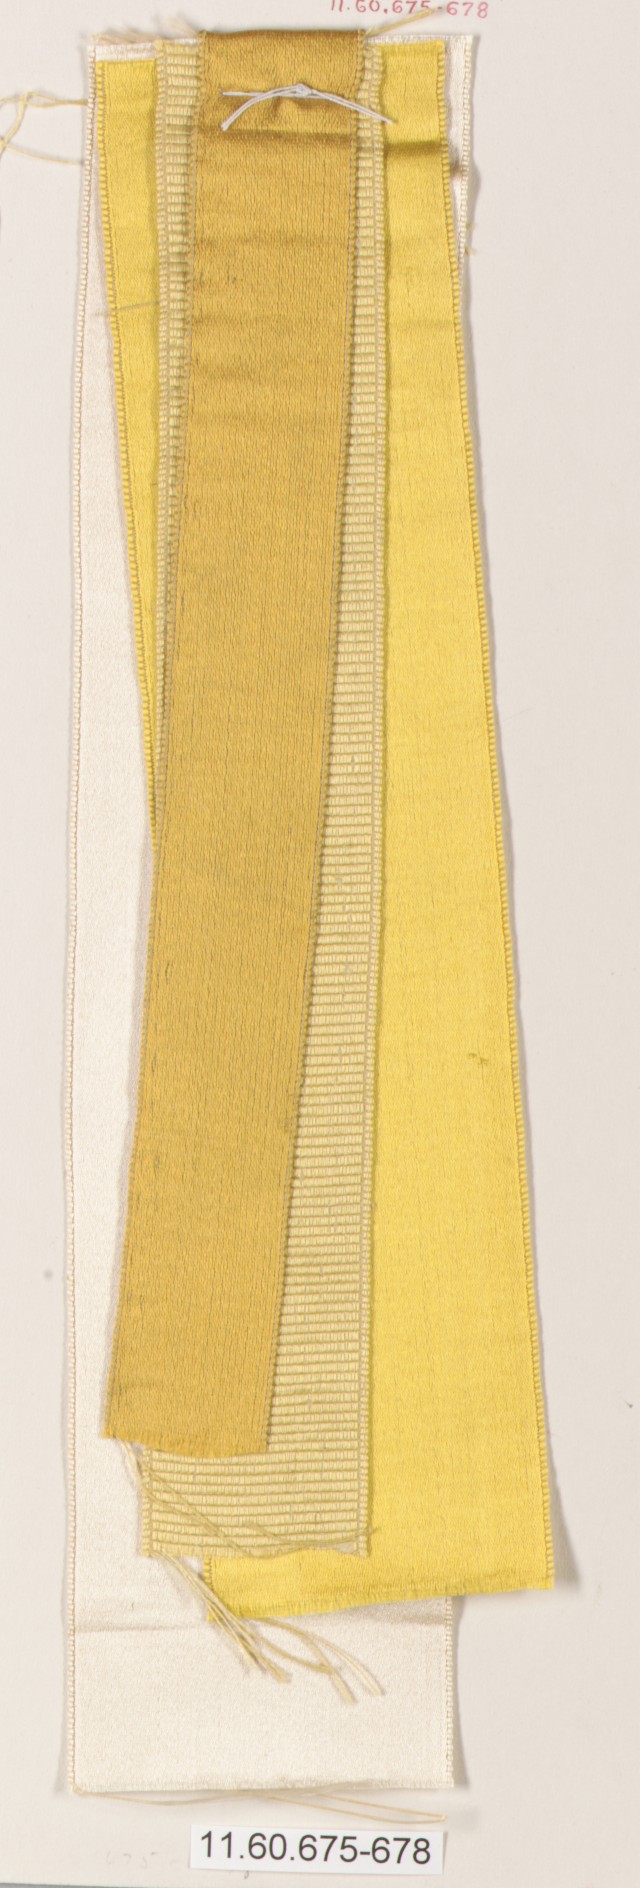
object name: ribbon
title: Ribbons (4)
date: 1801-1900